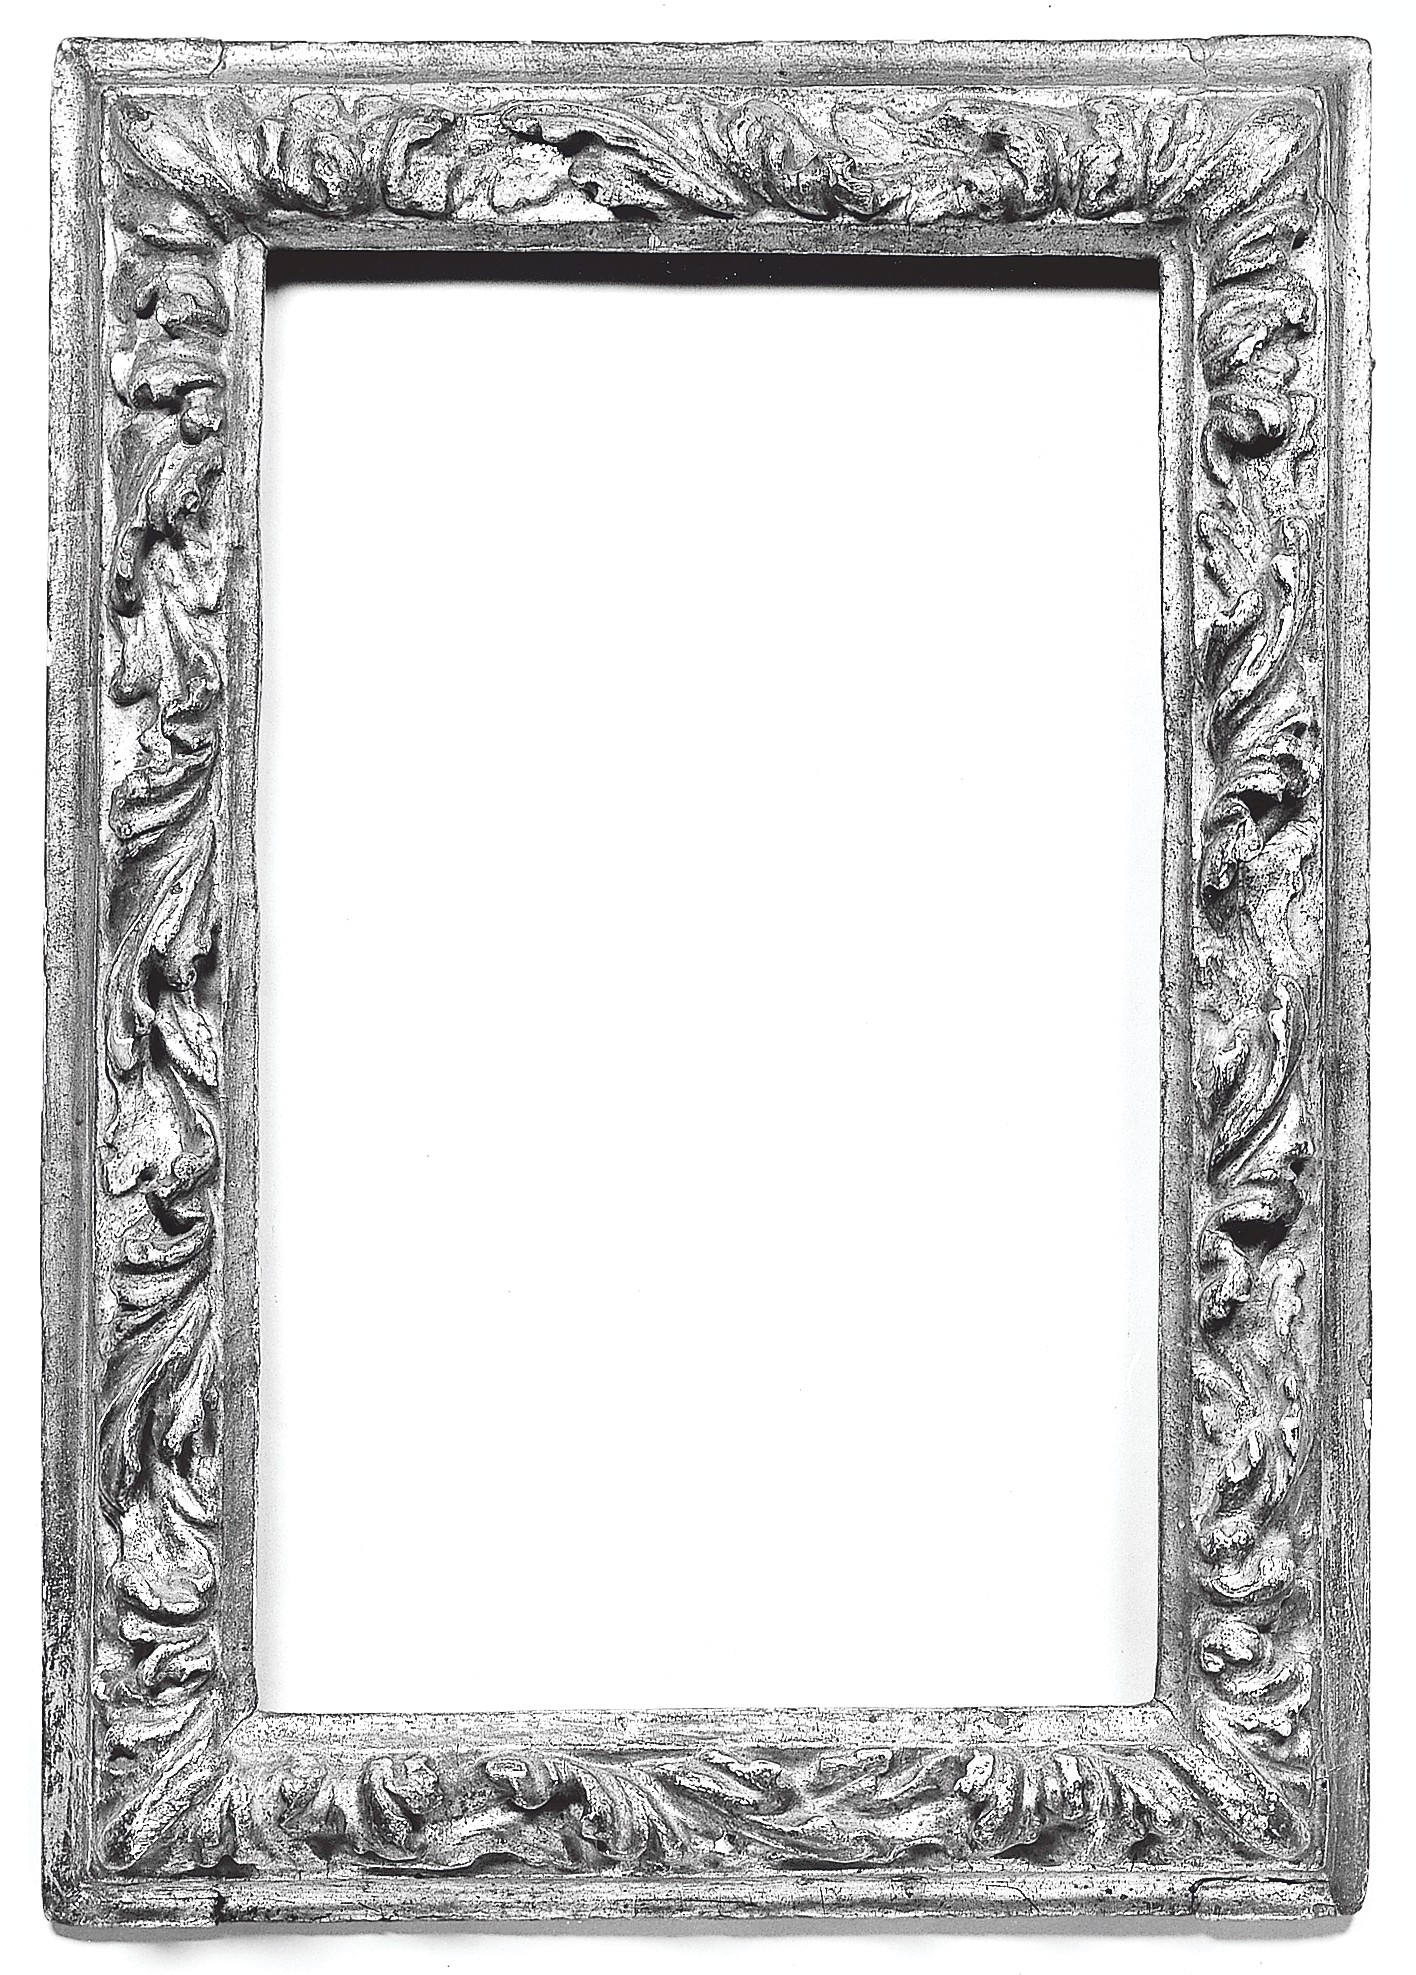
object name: frame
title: Astragal frame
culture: italian, veneto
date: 1601-1633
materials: wood